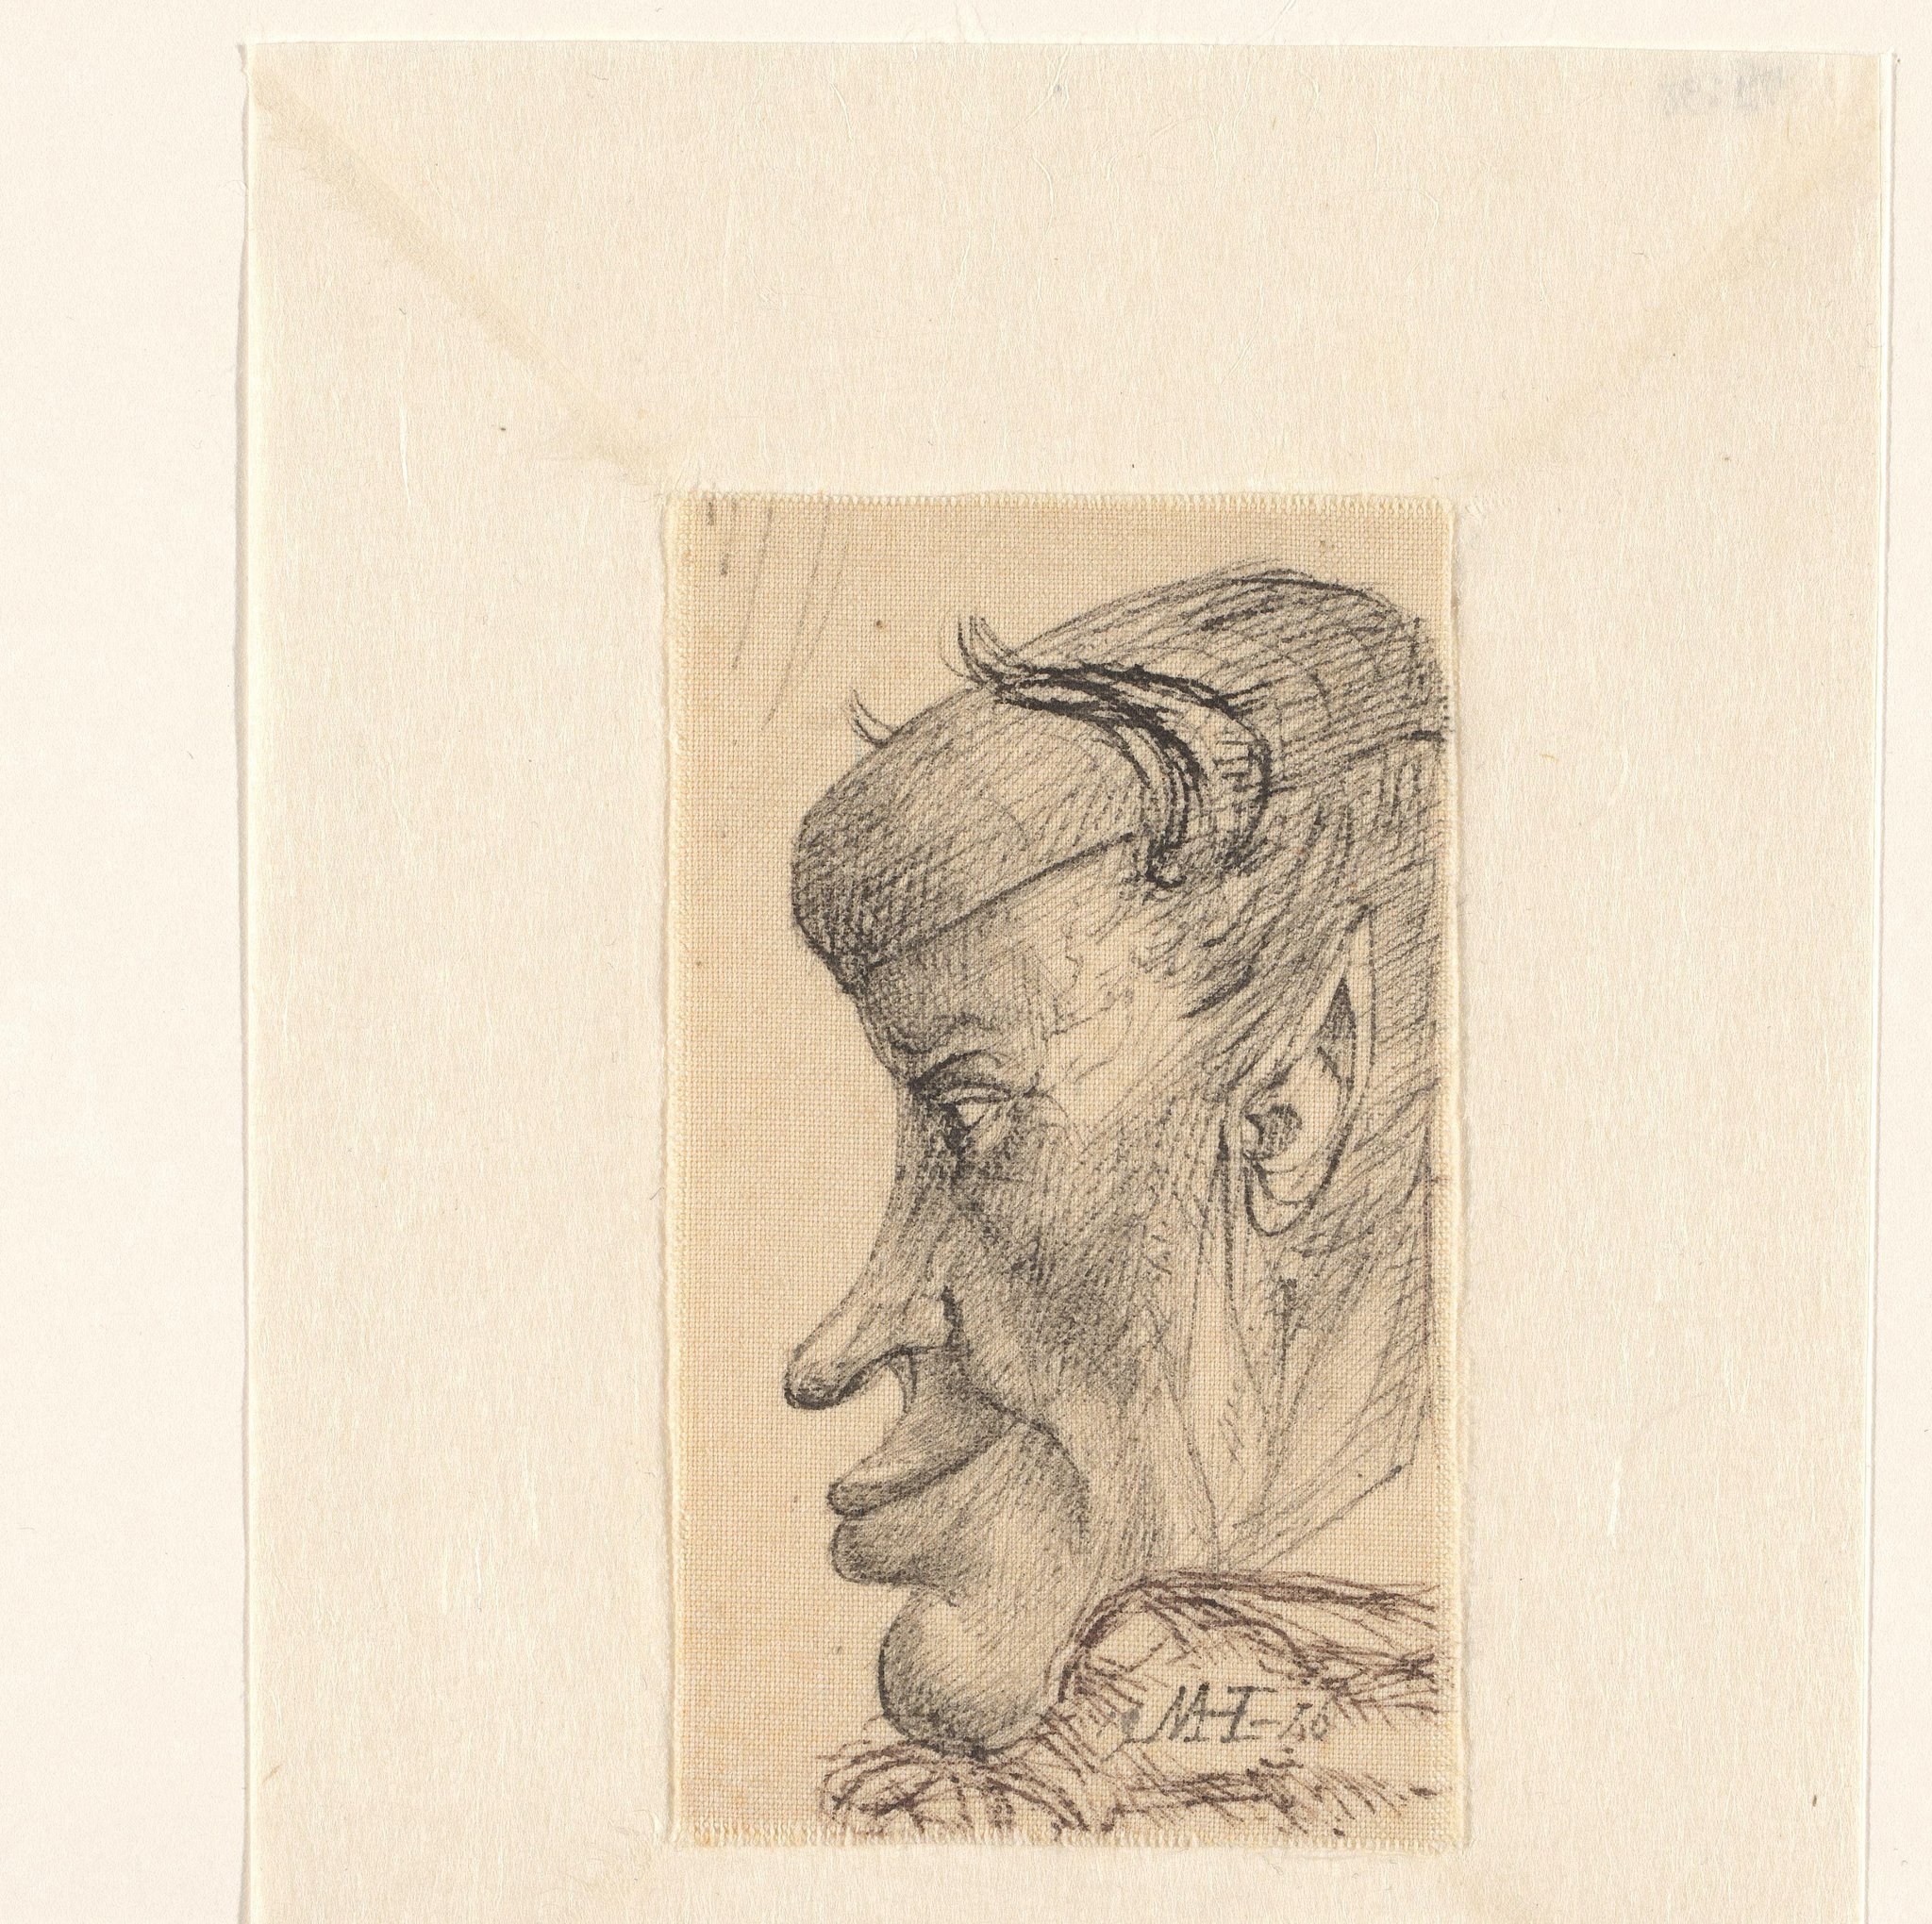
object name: drawing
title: Kop van een man met karikaturale gelaatstrekken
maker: marius holleman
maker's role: draughtsman, print maker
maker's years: 1878-1926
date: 1916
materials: ink, linen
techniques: pen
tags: caricatures (human types), head-gear: hat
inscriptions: date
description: Kop van een man met karikaturaal weergegeven gelaatstrekken, zoals spitse oren en een uitvergrote kin en neus. De man draagt een hoofddeksel.